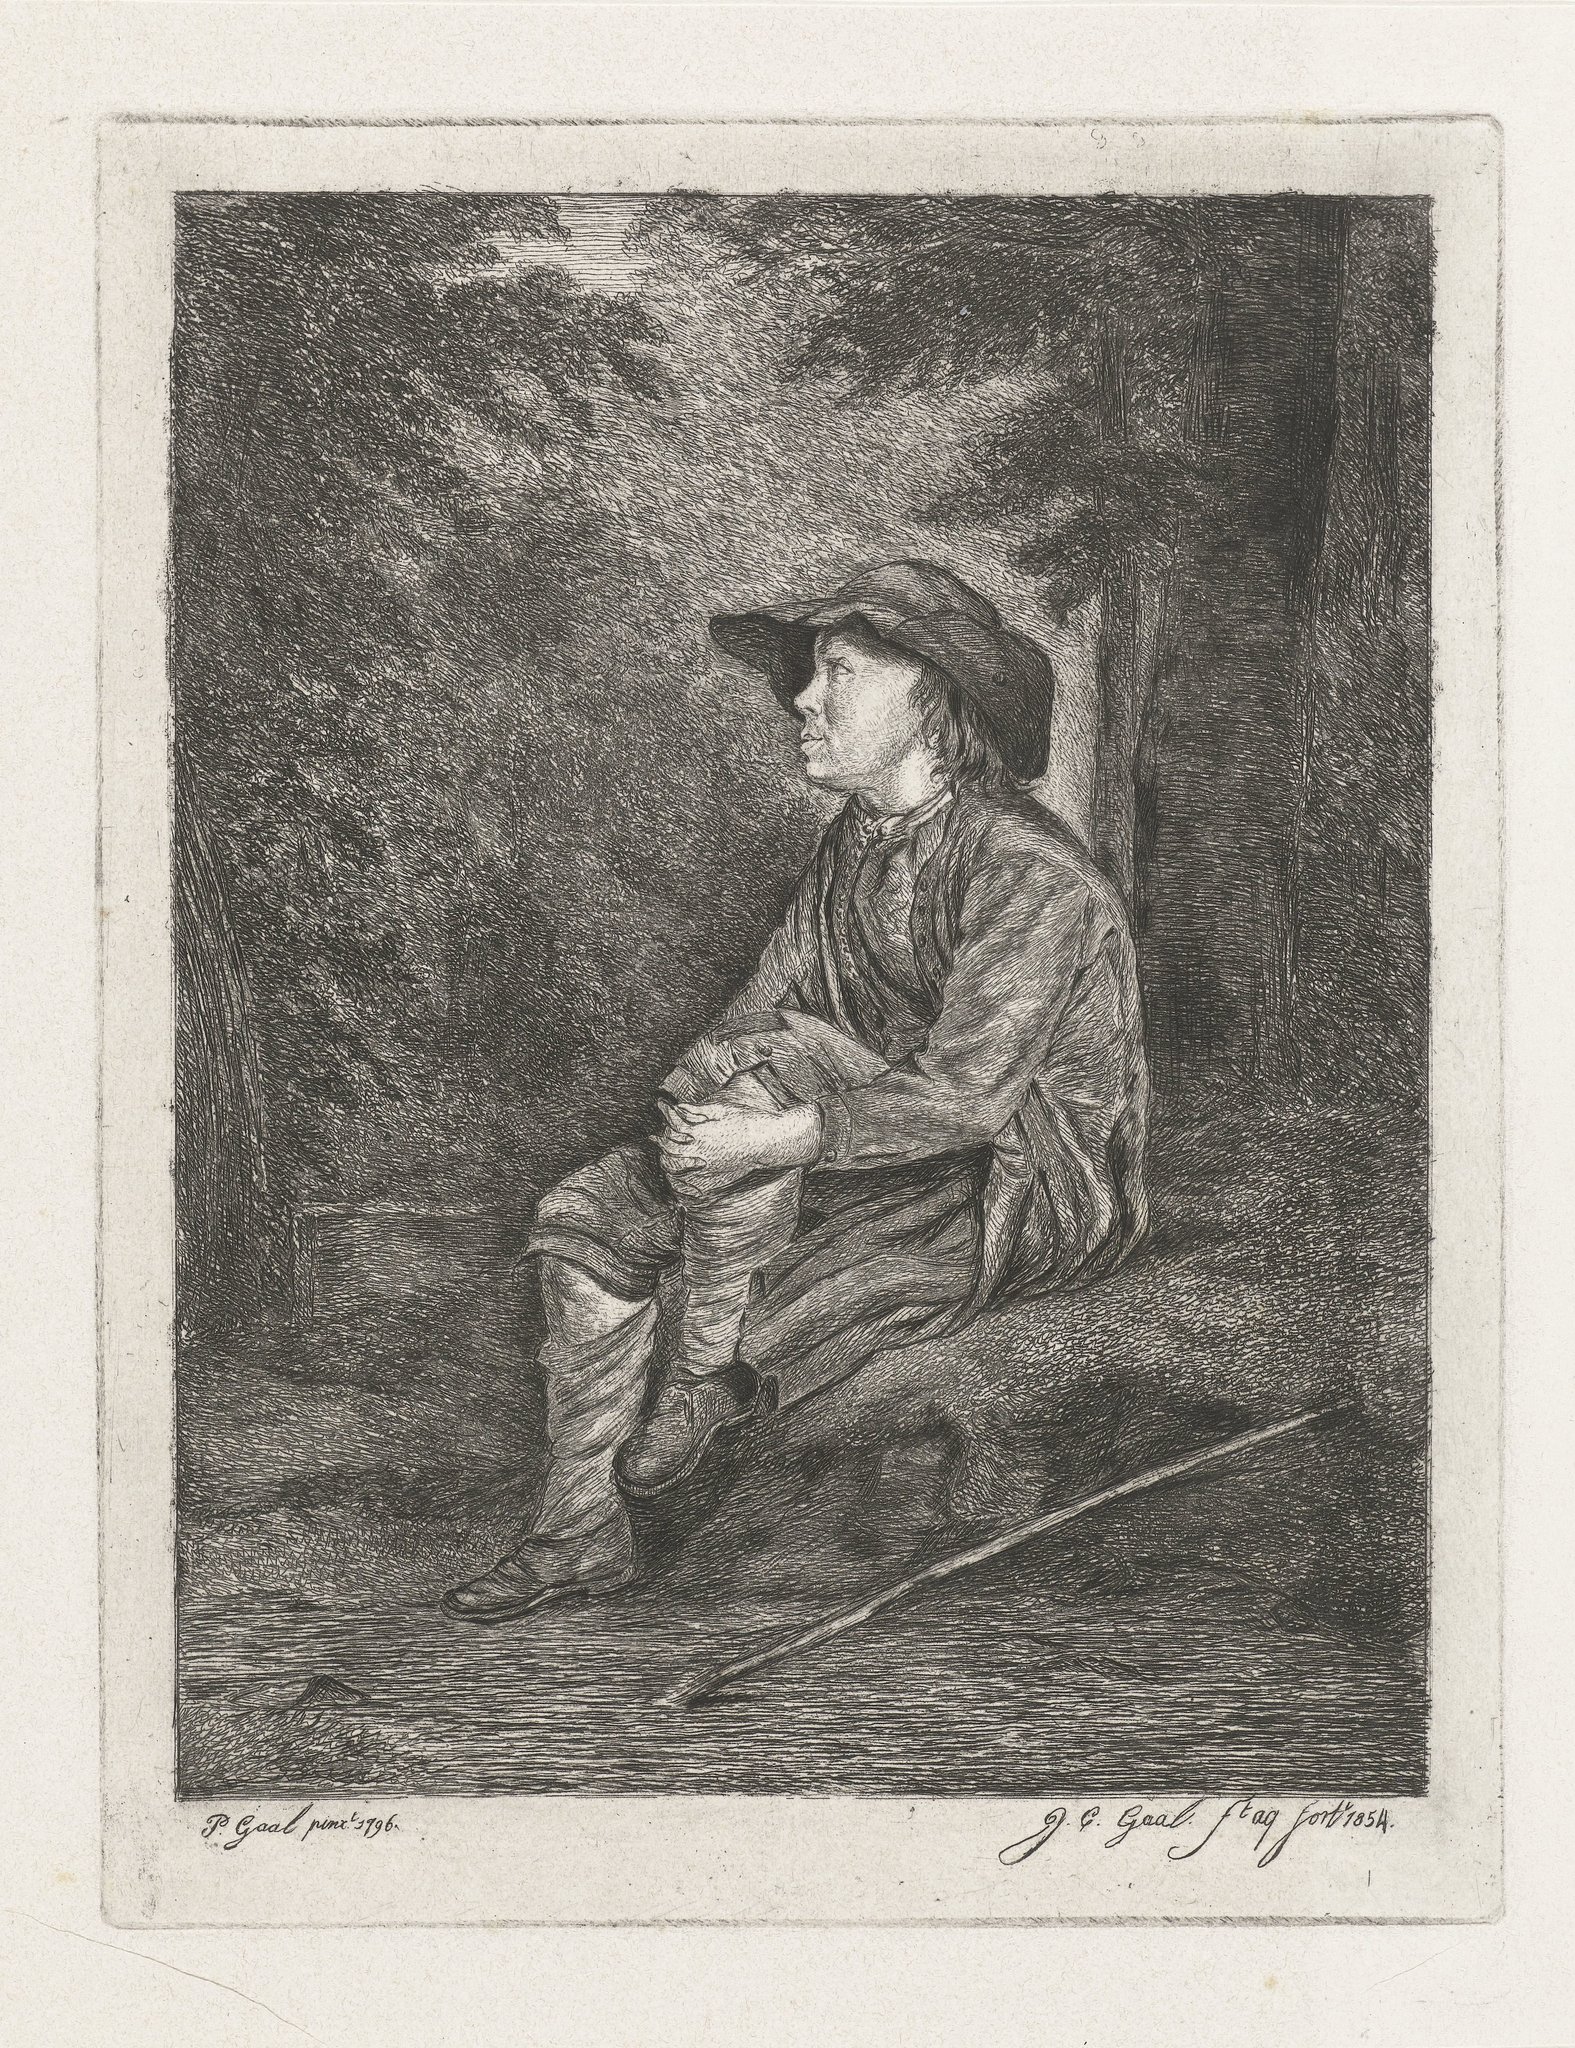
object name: print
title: Zittend jongetje in het bos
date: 1854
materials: paper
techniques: etching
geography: netherlands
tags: forest, wood (+ landscape with figures, staffage)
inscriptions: collector's mark: Lugt 2228